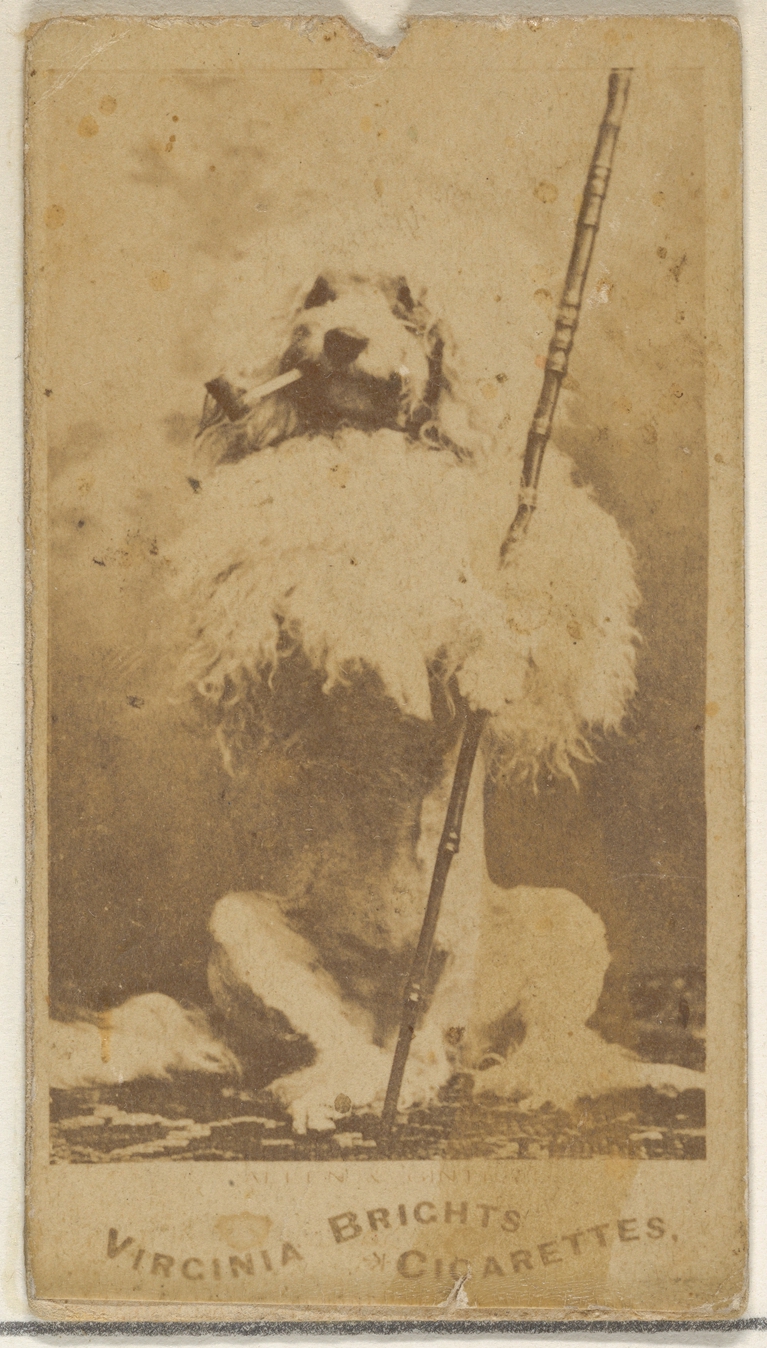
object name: photograph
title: From the Dogs series (N47) for Virginia Brights Cigarettes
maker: allen & ginter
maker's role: publisher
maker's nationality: american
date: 1888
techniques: albumen silver print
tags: dogs